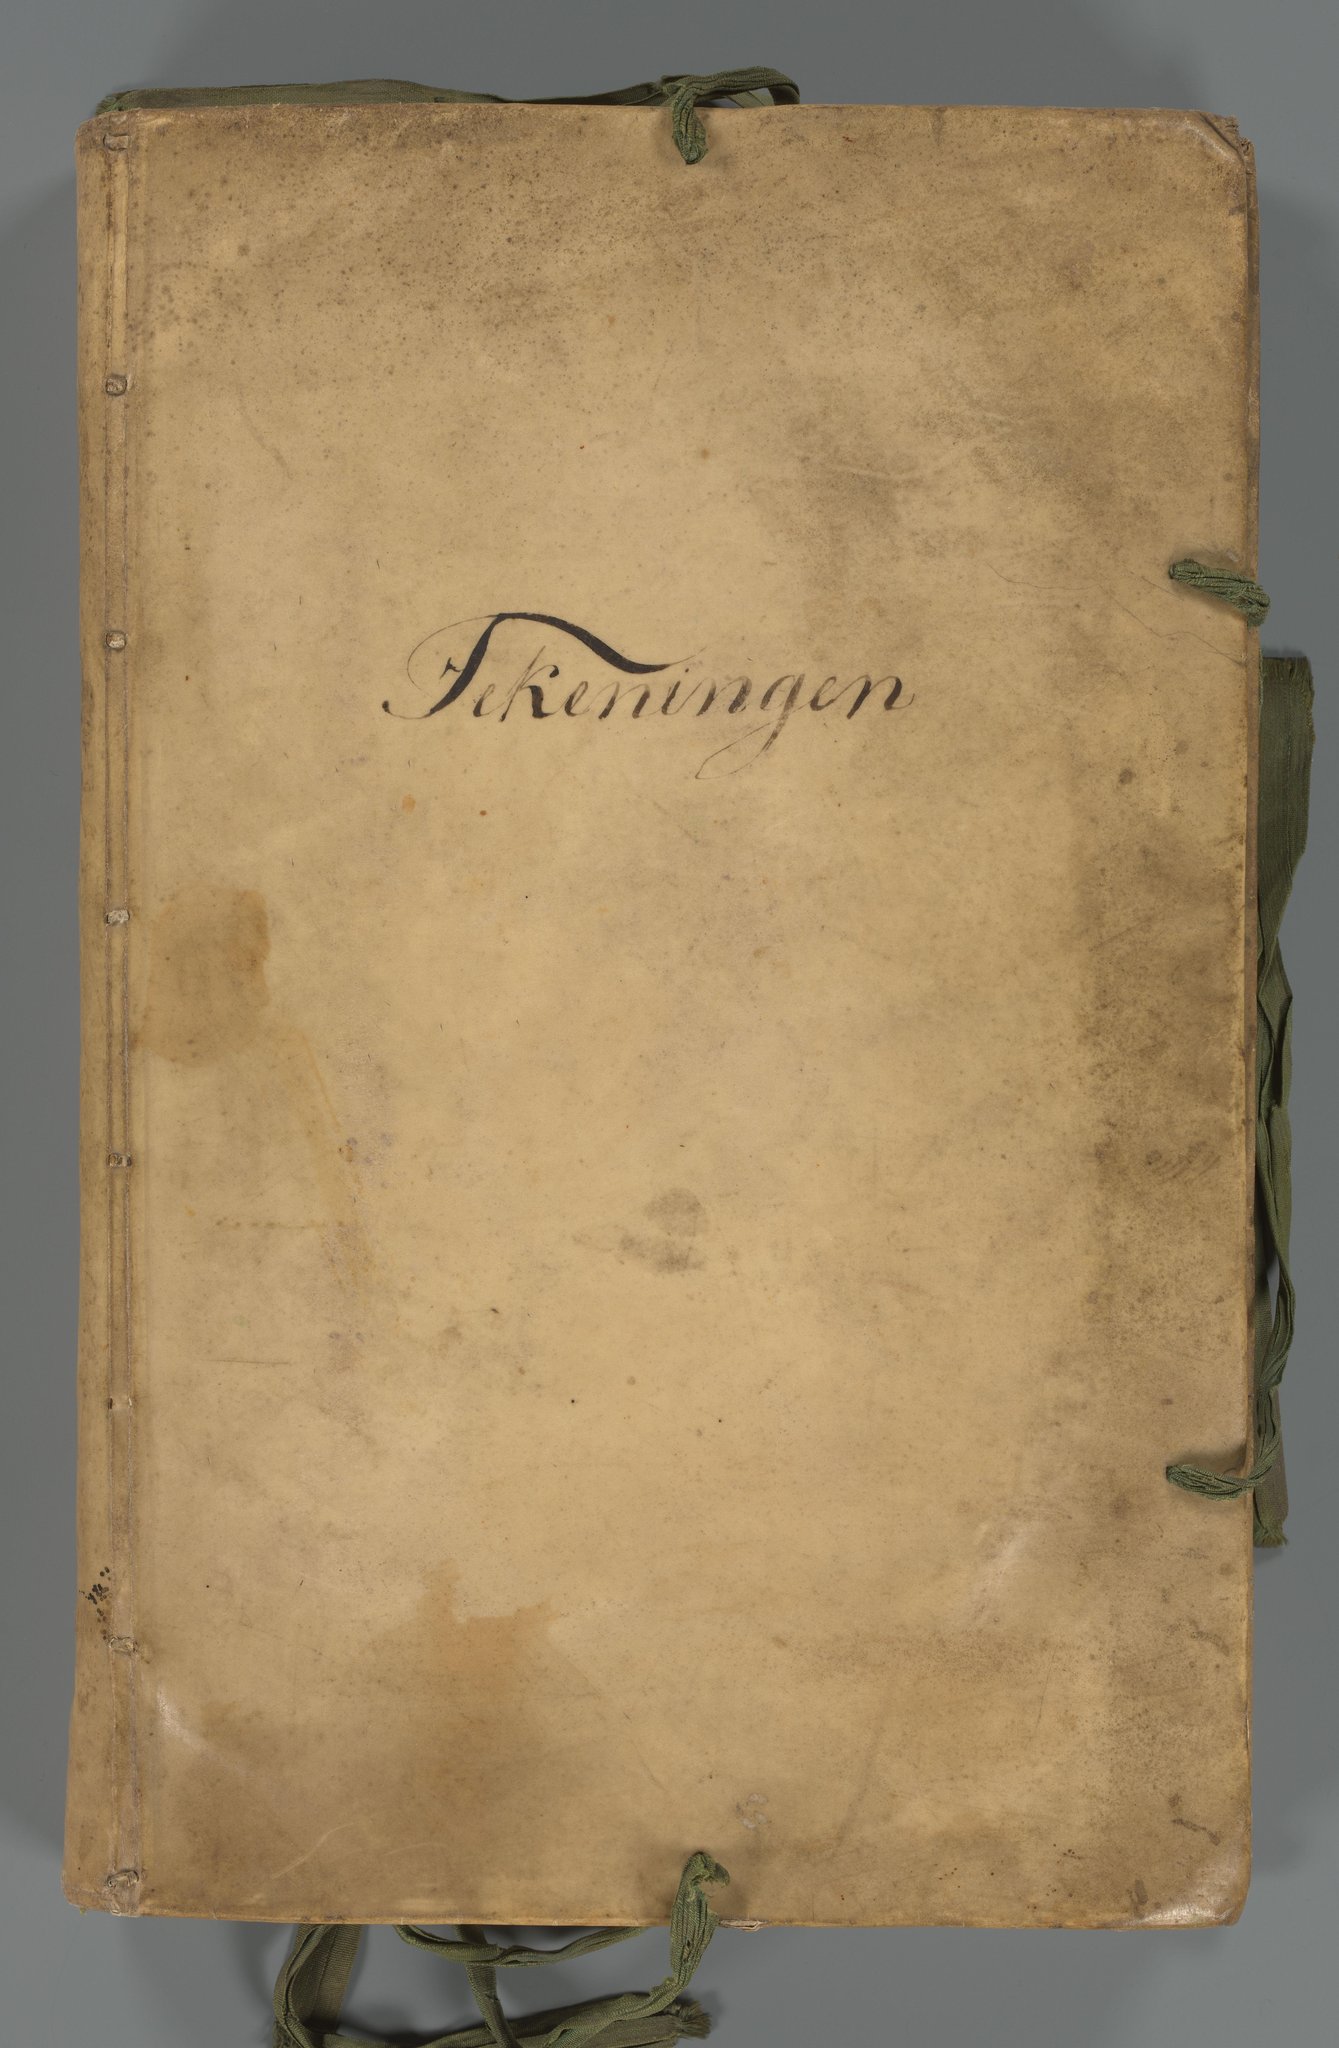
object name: verzamelalbum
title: Album met landschappen en bijbelse en mythologische taferelen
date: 1615-1799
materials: chalk, paint, paper, parchment, pencil, textile, watercolor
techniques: brush, woodcut, printmaking, etching, pen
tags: city-view, and landscape with man-made constructions, bible, classical mythology and ancient history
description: Album met 147 tekeningen die los tussen de bladen van het album liggen. De meeste tekeningen zijn van Matthijs Balen, deels gesigneerd, en bevatten met name bijbelse en mythologische scènes. Andere tekeningen zijn (mogelijk) van Johan Johansz. Balen. Een deel van de tekeningen is ongesigneerd. De tekeningen van Nicolaes Maes (RP-T-1957-154 tot en met -163, -165, -167 en -168) zijn eruit gehaald en vervangen door foto's. Daarnaast bevat het album twee prenten, één ets en één clair-obscur-houtsnede.